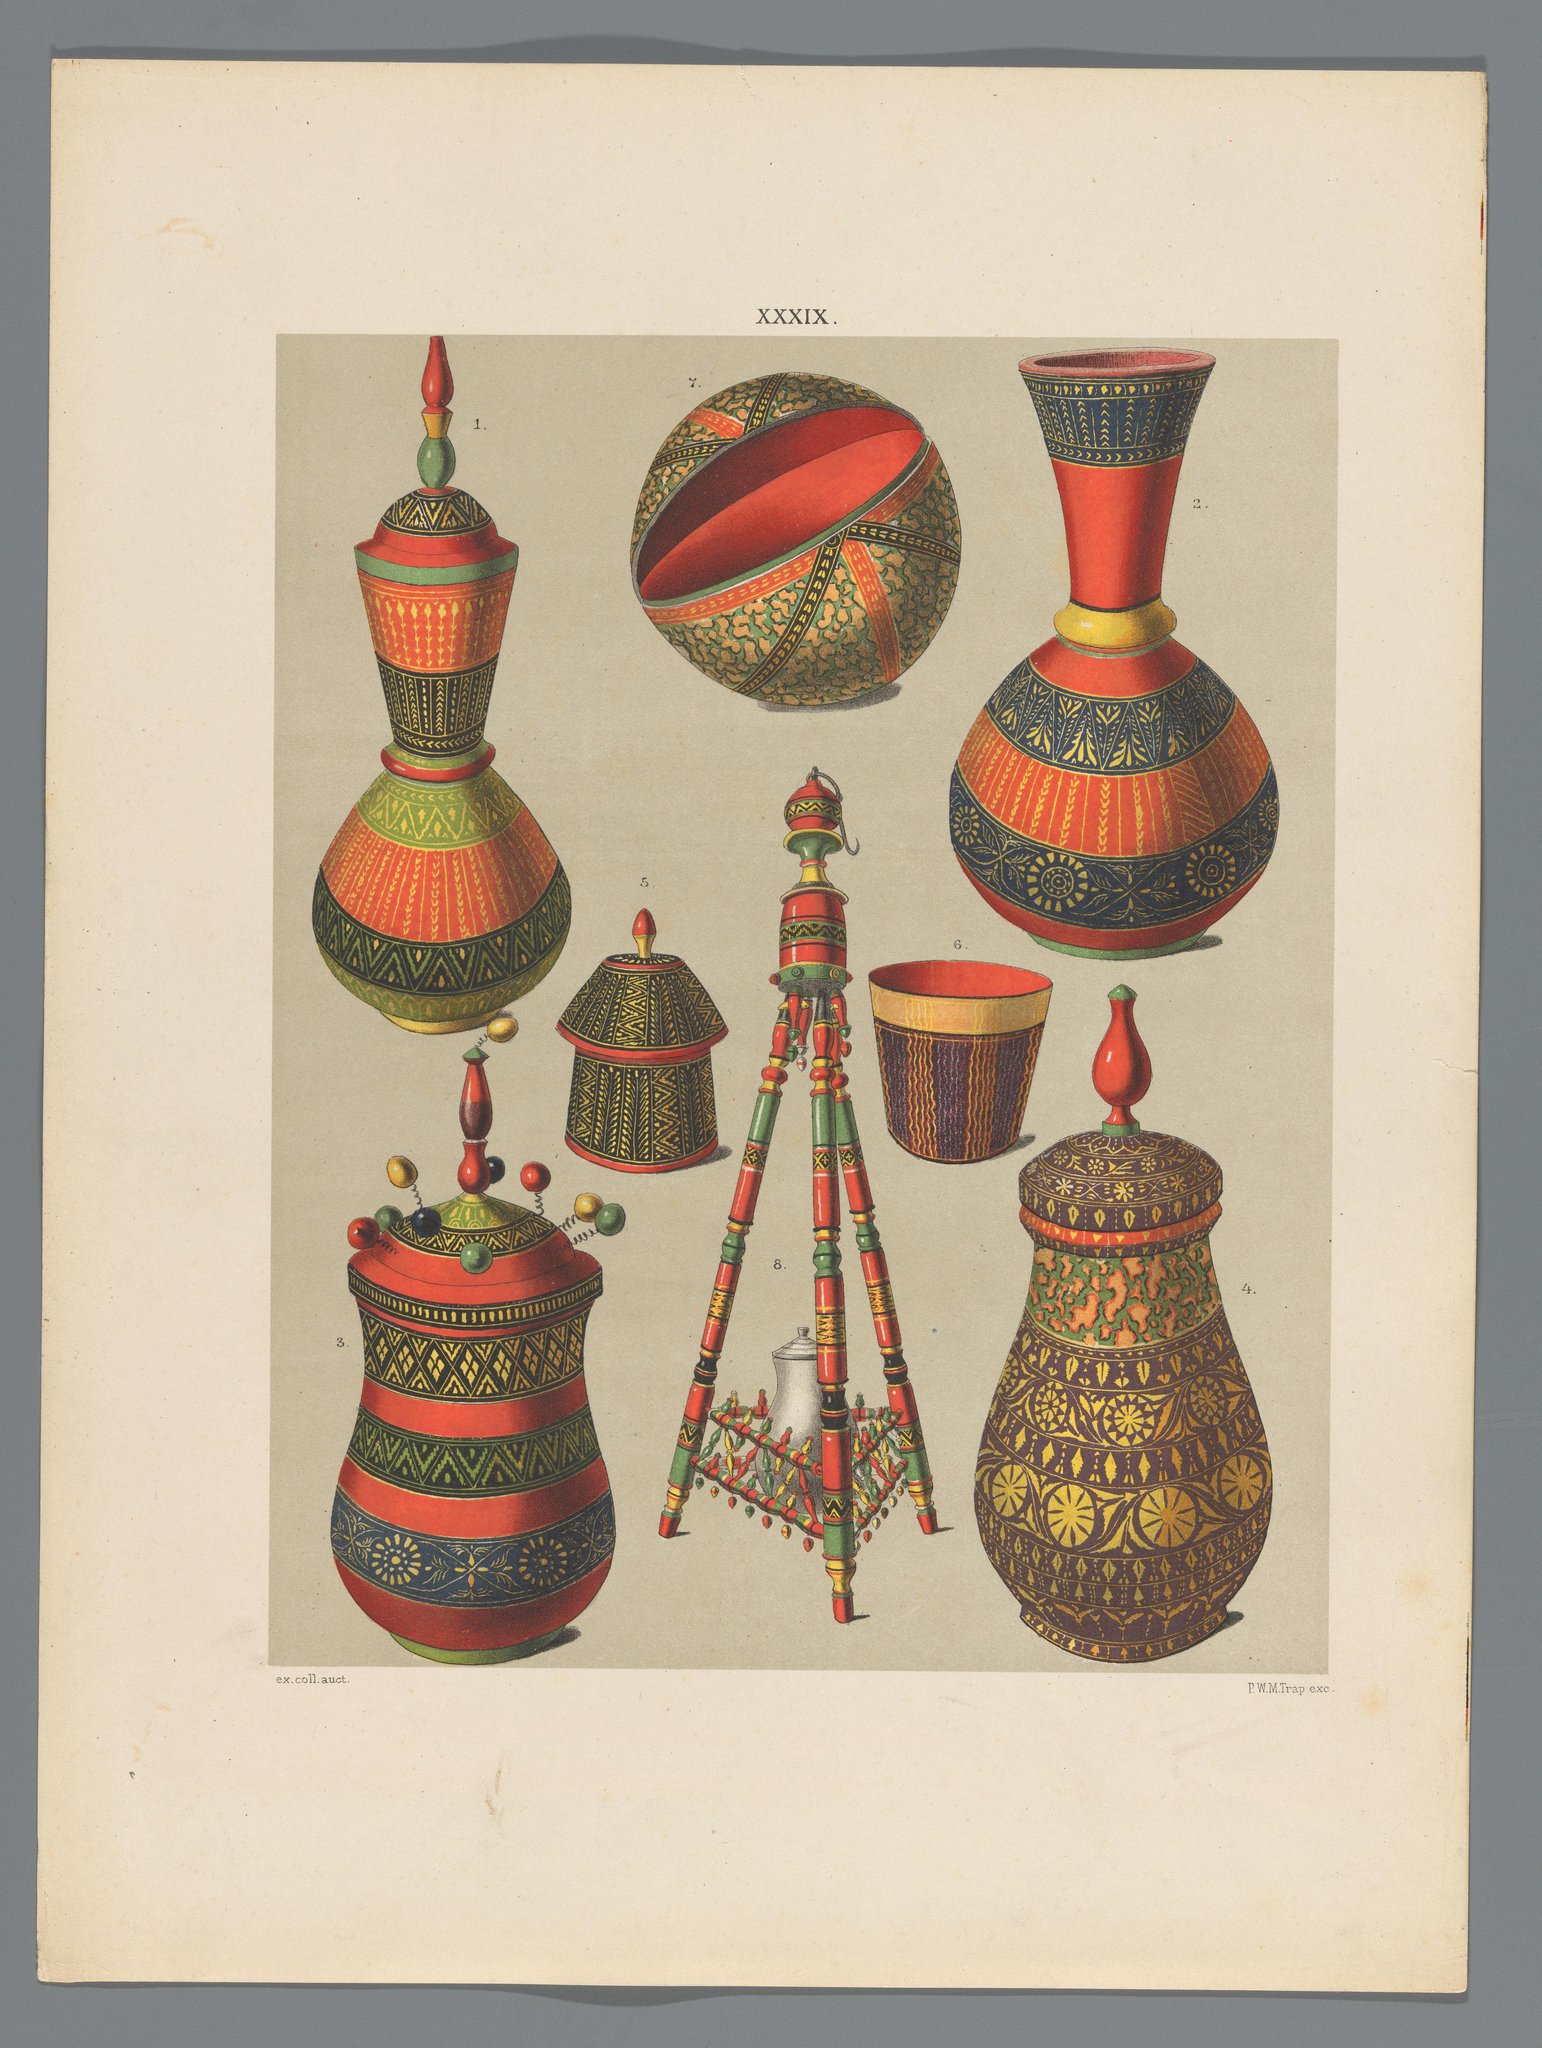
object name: print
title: In Mekka gebräuchliche Gegenstände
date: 1883-1888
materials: paper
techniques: lithograph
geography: leiden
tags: still life of miscellaneous objects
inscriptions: number: ‘XXXIX.’